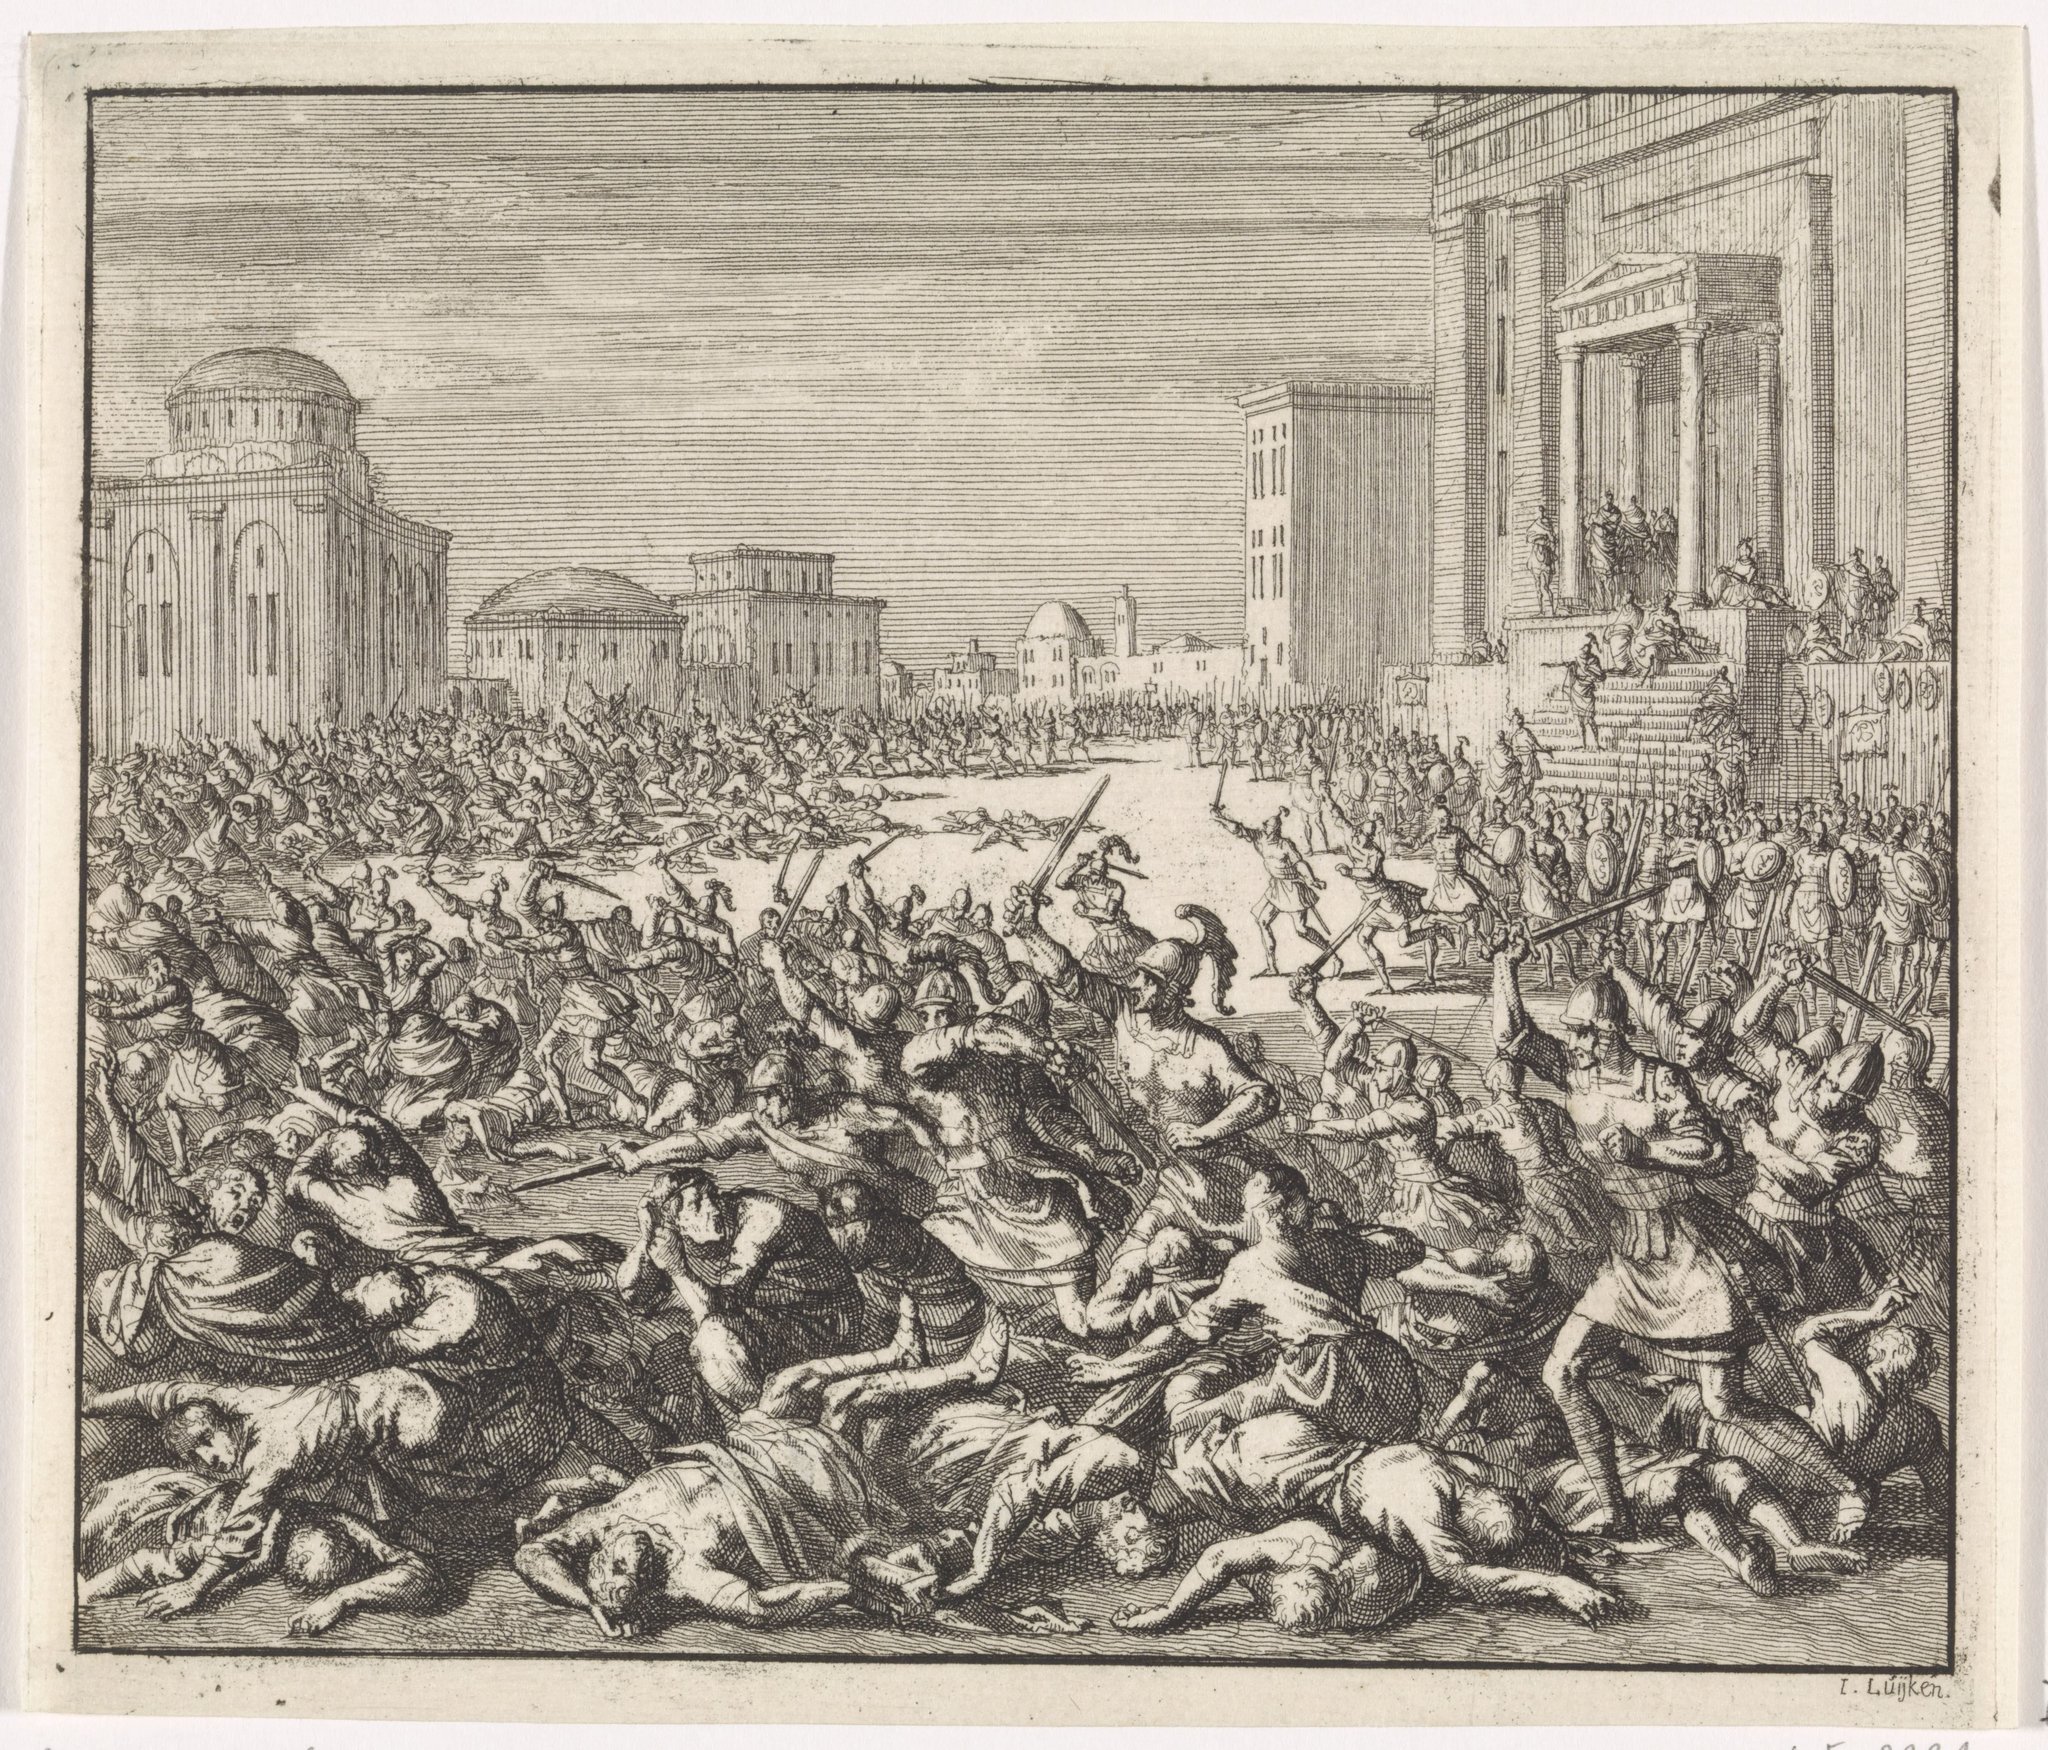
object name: print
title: Keizer Theodosius I laat zevenduizend bewoners van Thessaloniki afslachen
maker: jan luyken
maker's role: draughtsman, print maker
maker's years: 1649-1712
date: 1701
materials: paper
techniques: etching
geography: amsterdam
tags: violent death by sword, the early christian churches, e.g. armenians, copts, syrians, massacre ~ war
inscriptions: collector's mark: Lugt 2228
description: Proefdruk van een boekillustratie Arnold, Godfried. Waare afbeelding der eerste christenen. Amsterdam: Jacobus van Hardenberg, Barent Visscher en Jacobus van Nieuweveen, 1700, dl. 2.